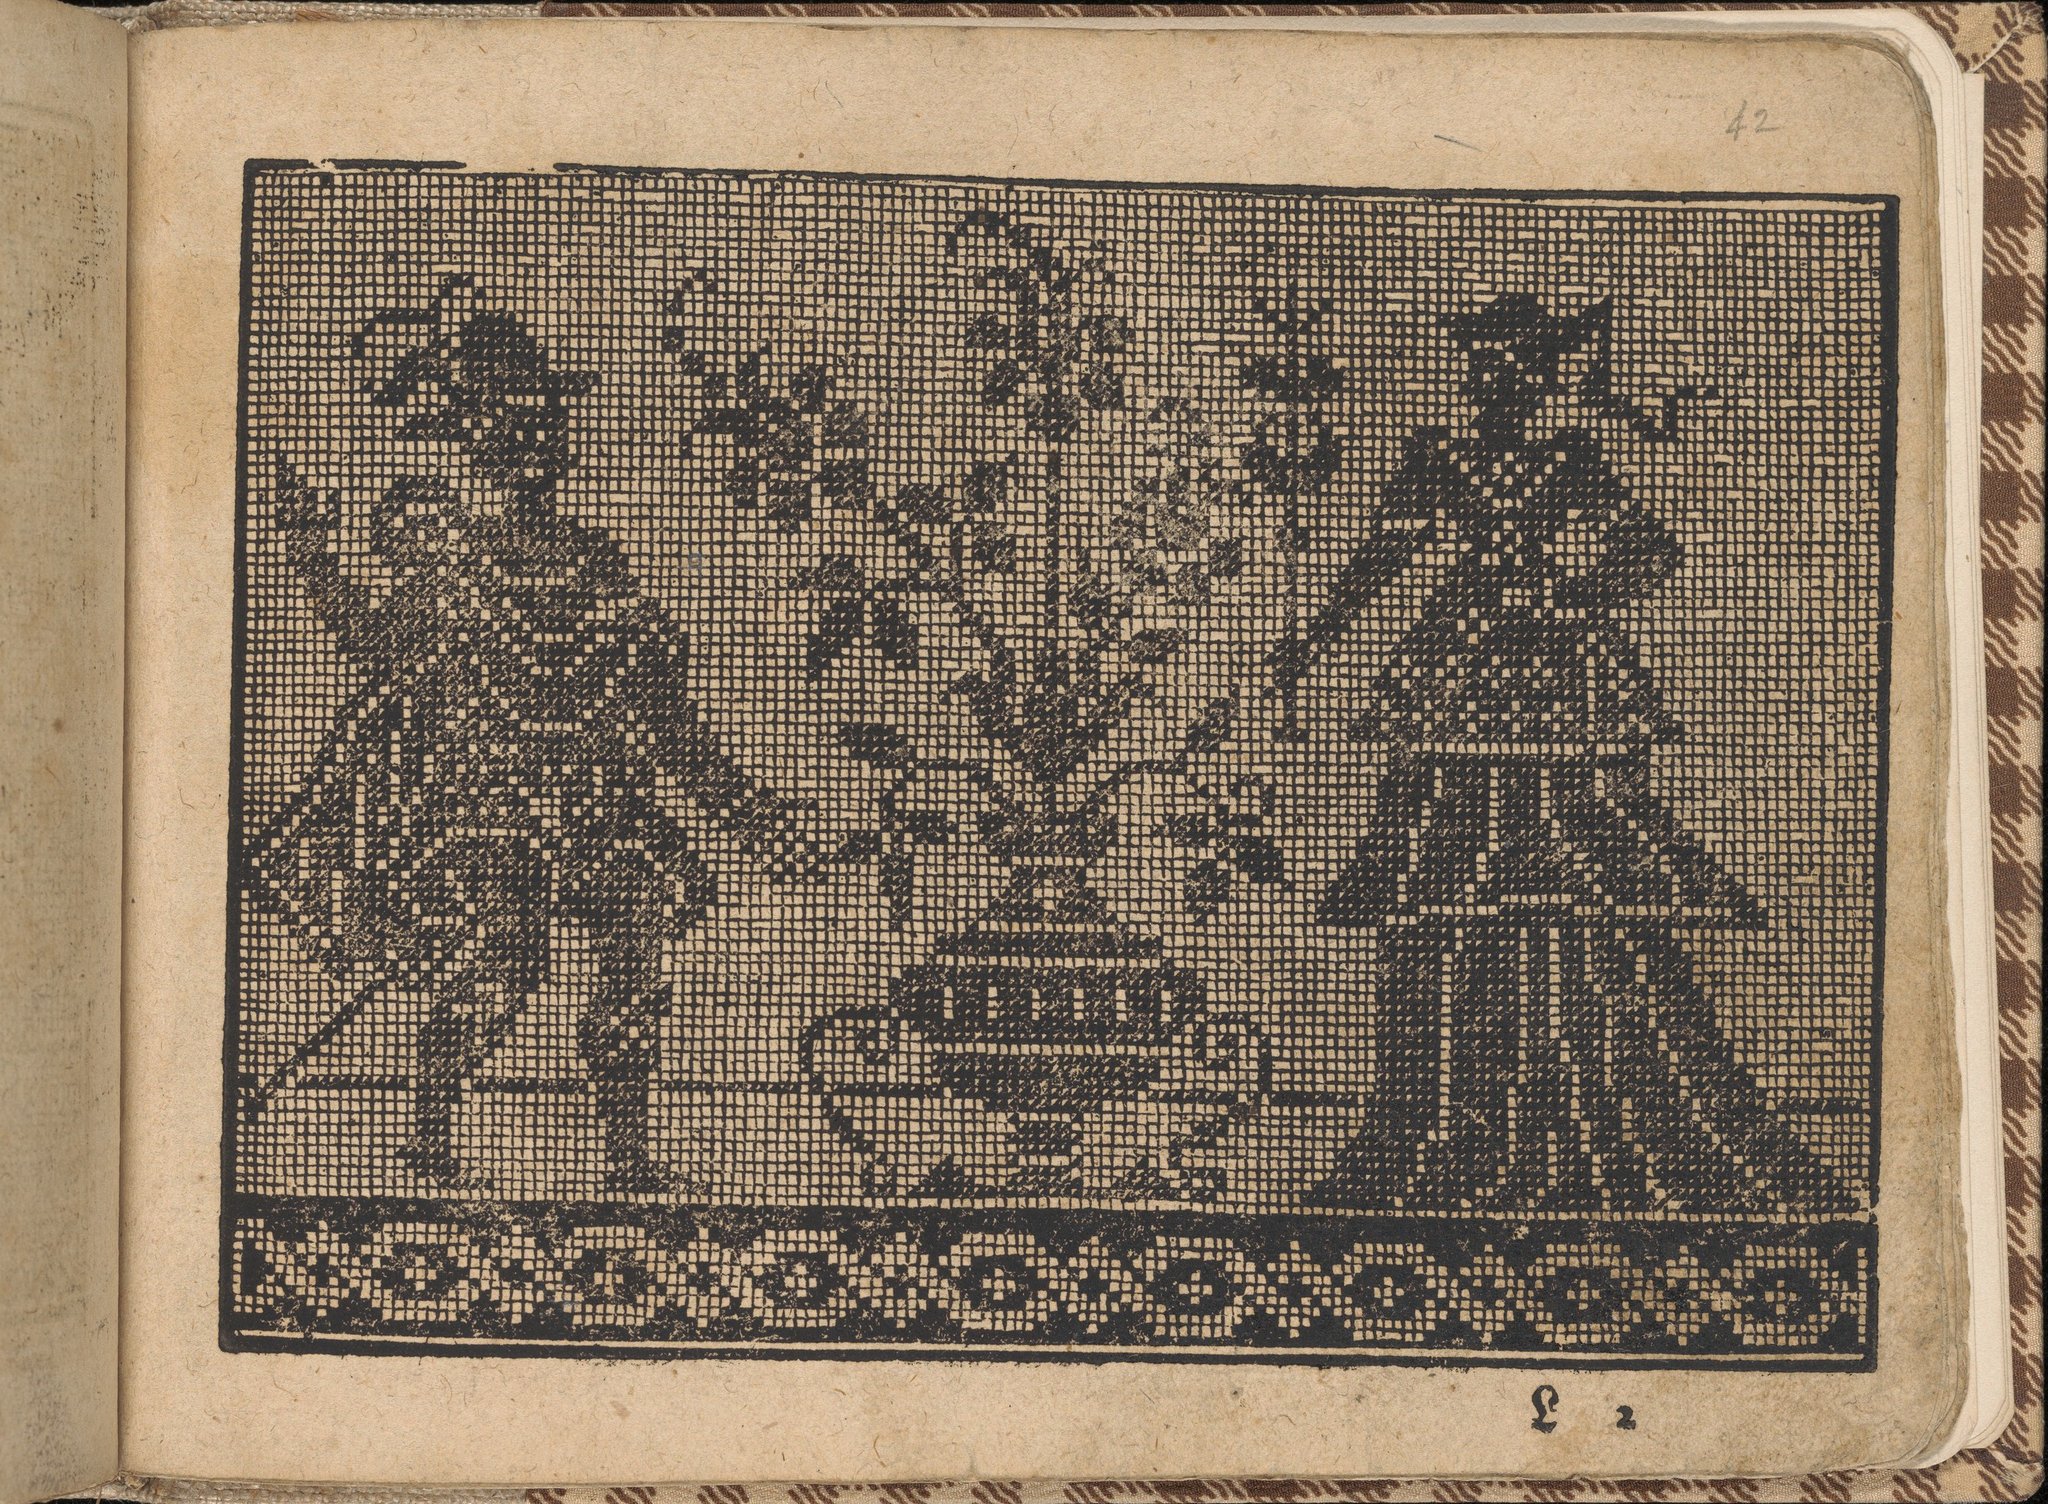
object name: book print ornament architecture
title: New Künstlichs Modelbuch (Page 42 recto)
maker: bernhard jobin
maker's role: publisher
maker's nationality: swiss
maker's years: 1535-1597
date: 1600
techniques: woodcut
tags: men,women,vases